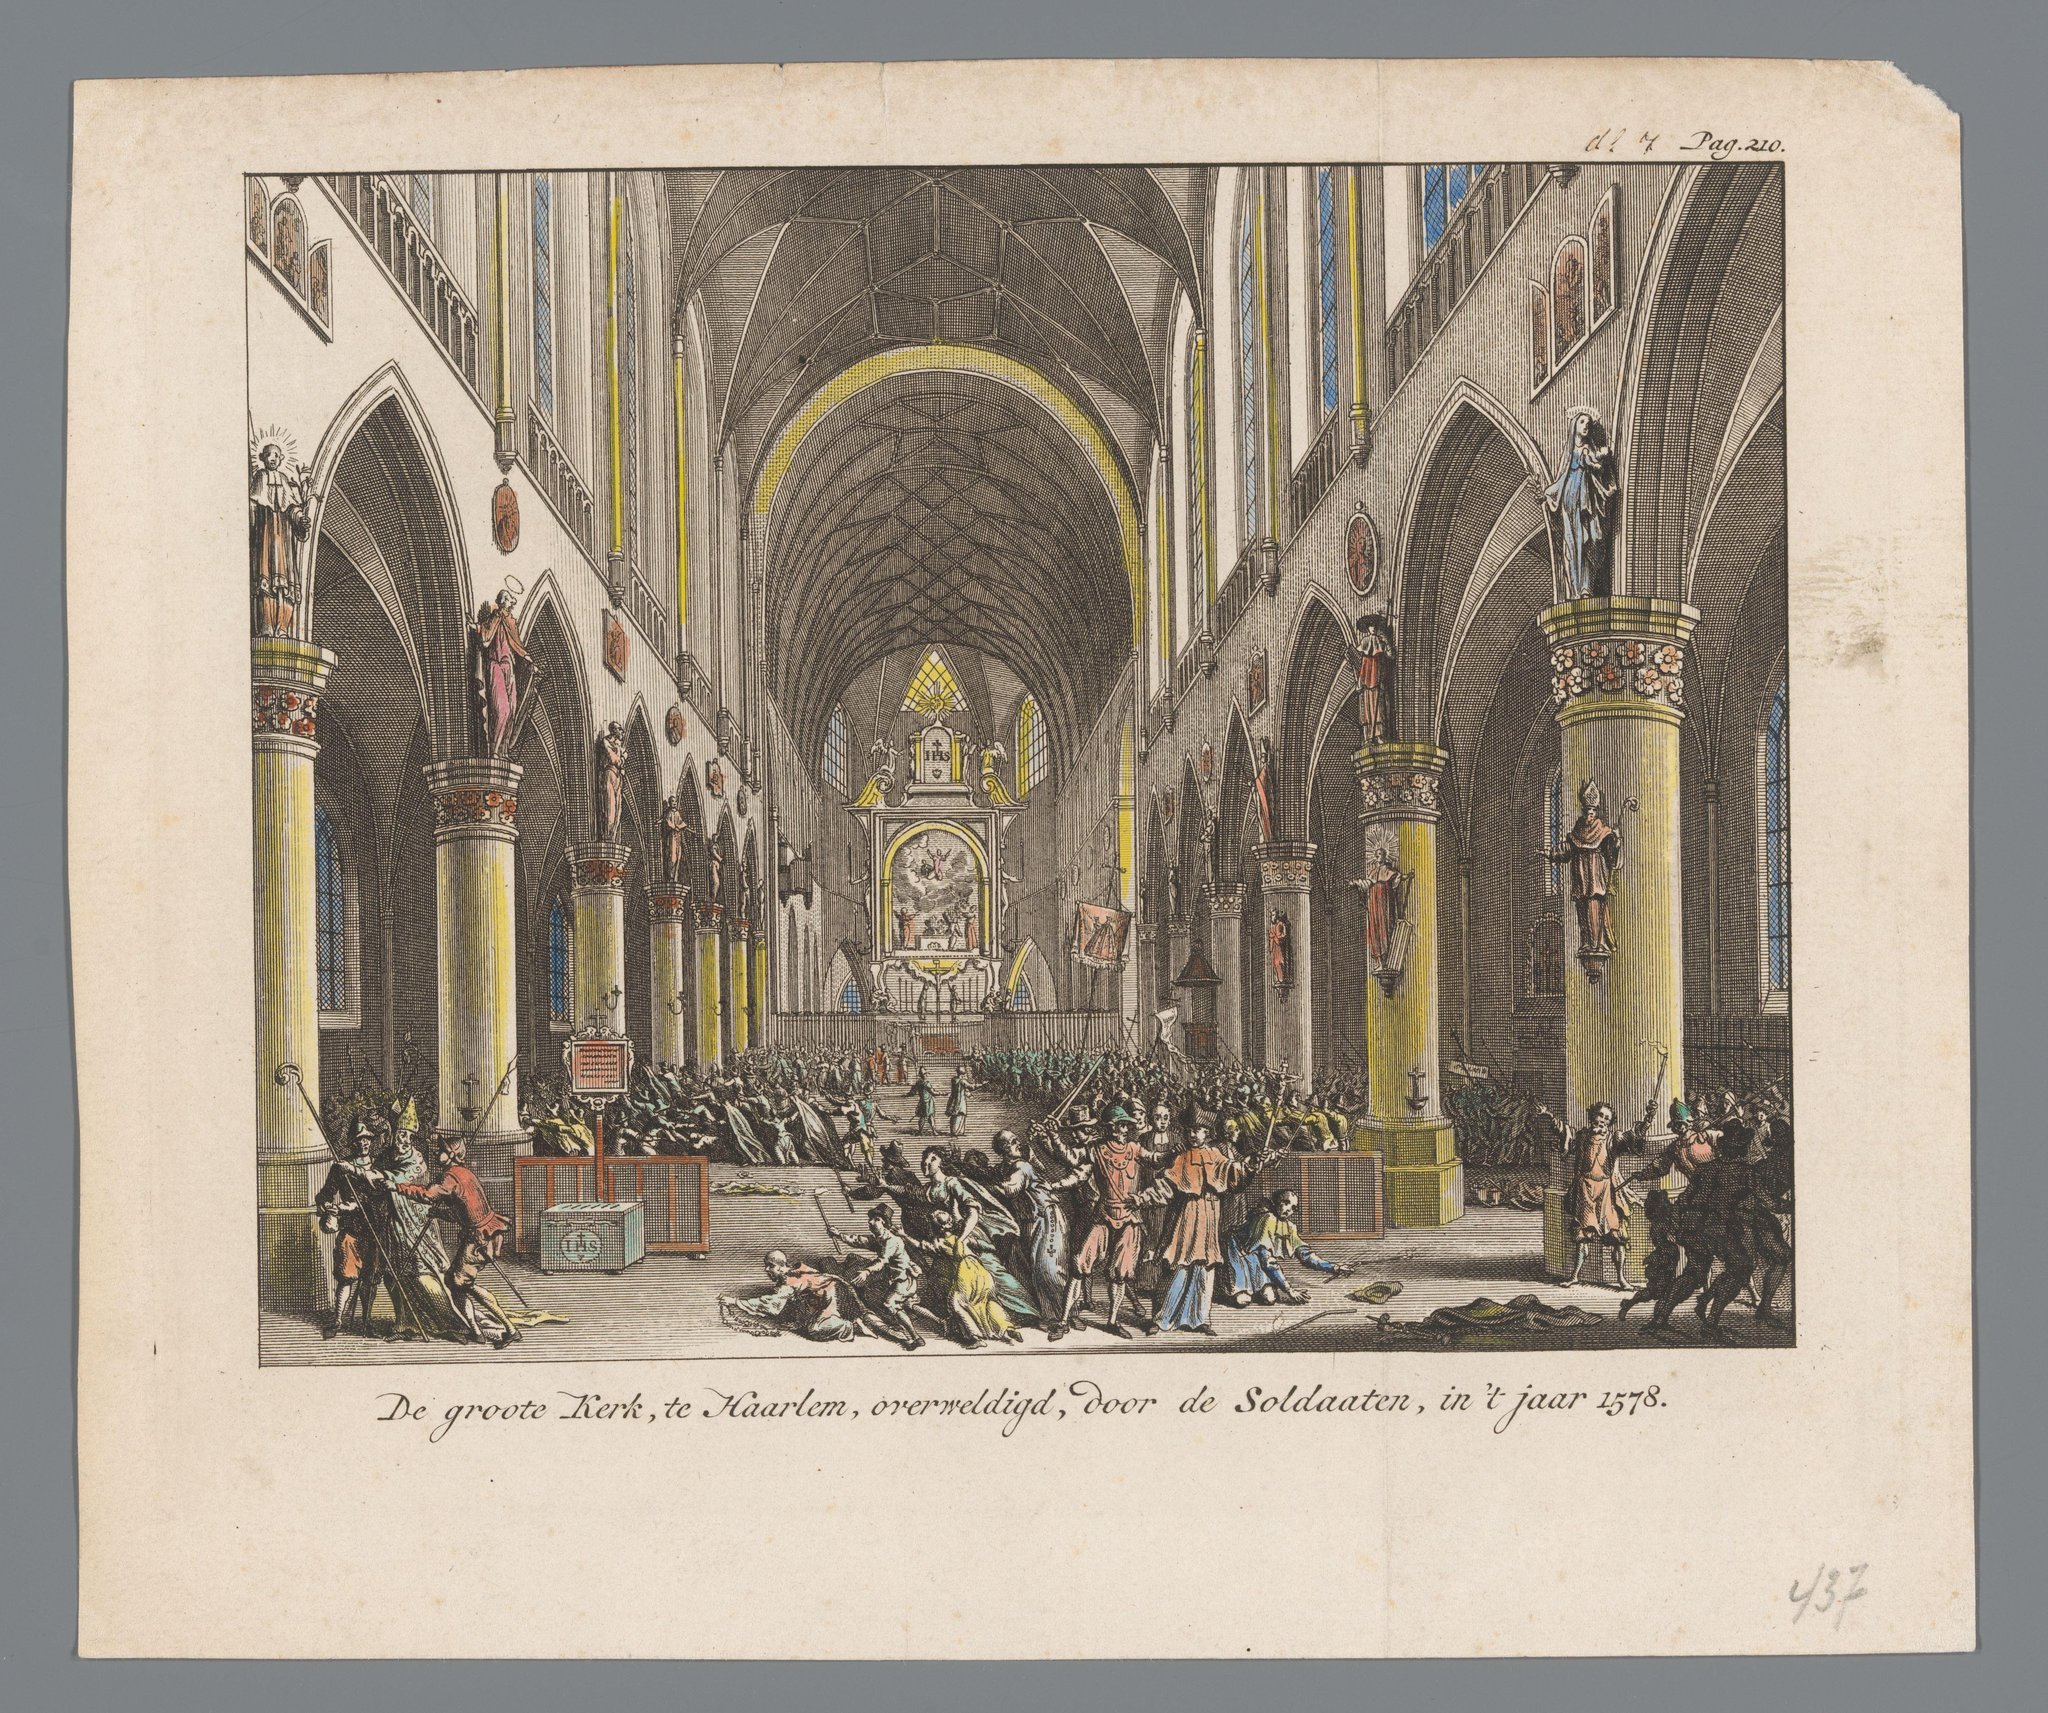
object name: print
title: Bestorming door protestanten van de Sint-Bavokerk in Haarlem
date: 1752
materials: paper, watercolor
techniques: etching, hand coloring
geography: amsterdam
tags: interior of church, plundering of churchbuilding, convent, etc.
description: Prent uit: Wagenaar, Jan. Vaderlandsche historie, vervattende de geschiedenissen der Vereenigde Nederlanden, inzonderheid die van Holland (...). 23 dln. Amsterdam: Isaak Tirion, 1752, dl. 7, p. 210.